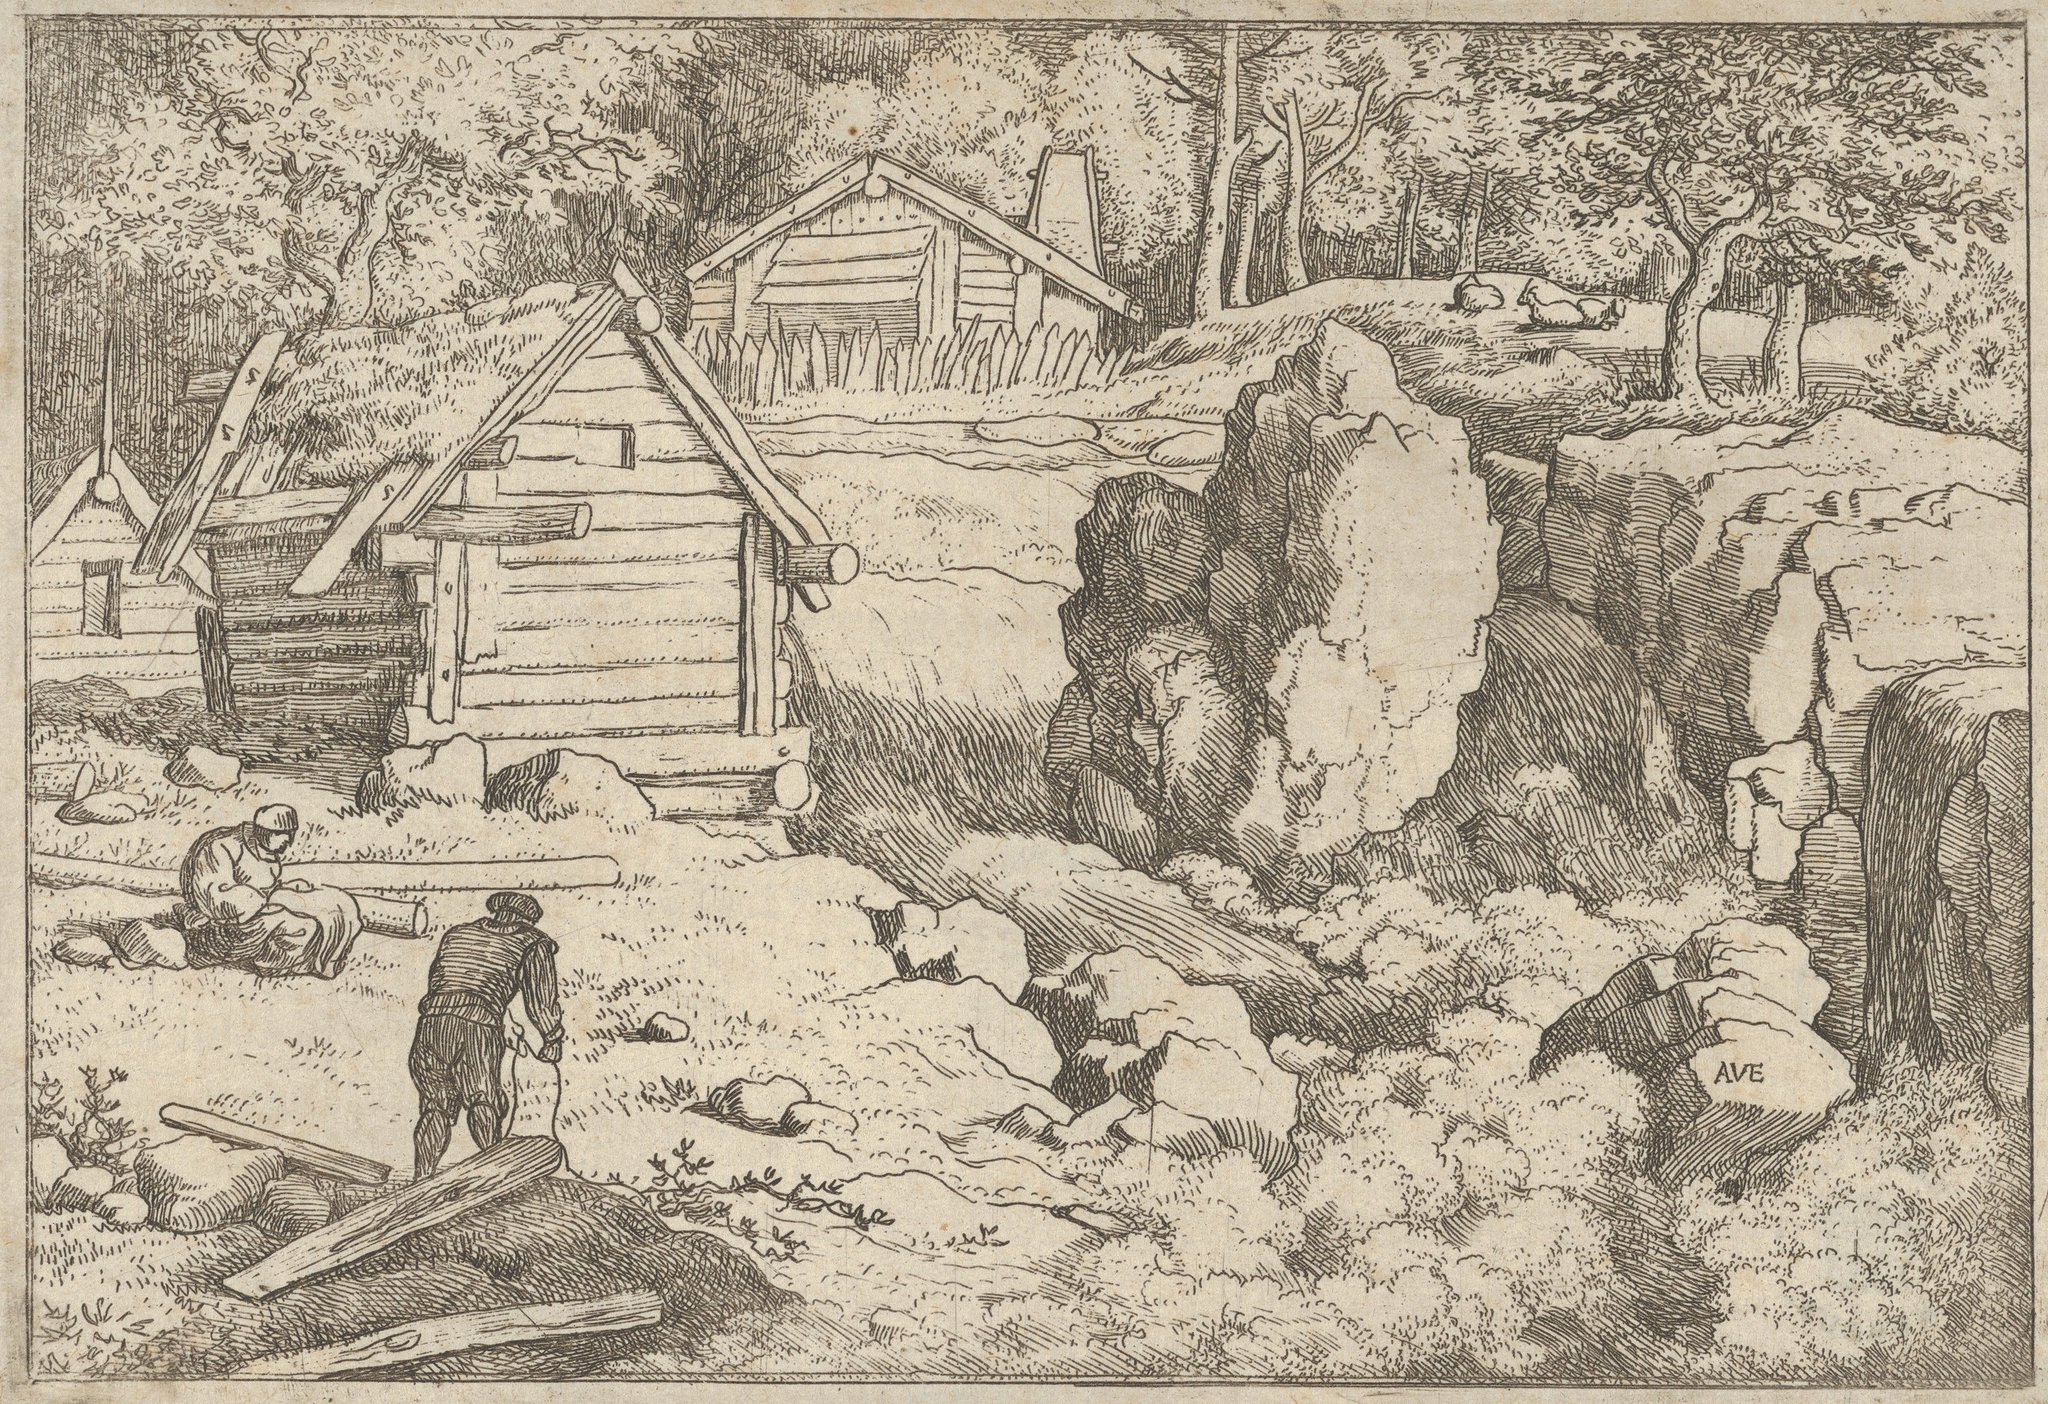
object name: print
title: The Carpenter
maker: allart van everdingen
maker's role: artist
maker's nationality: dutch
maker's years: 1621-1675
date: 1621-1675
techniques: engraving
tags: human figures,houses,trees,working